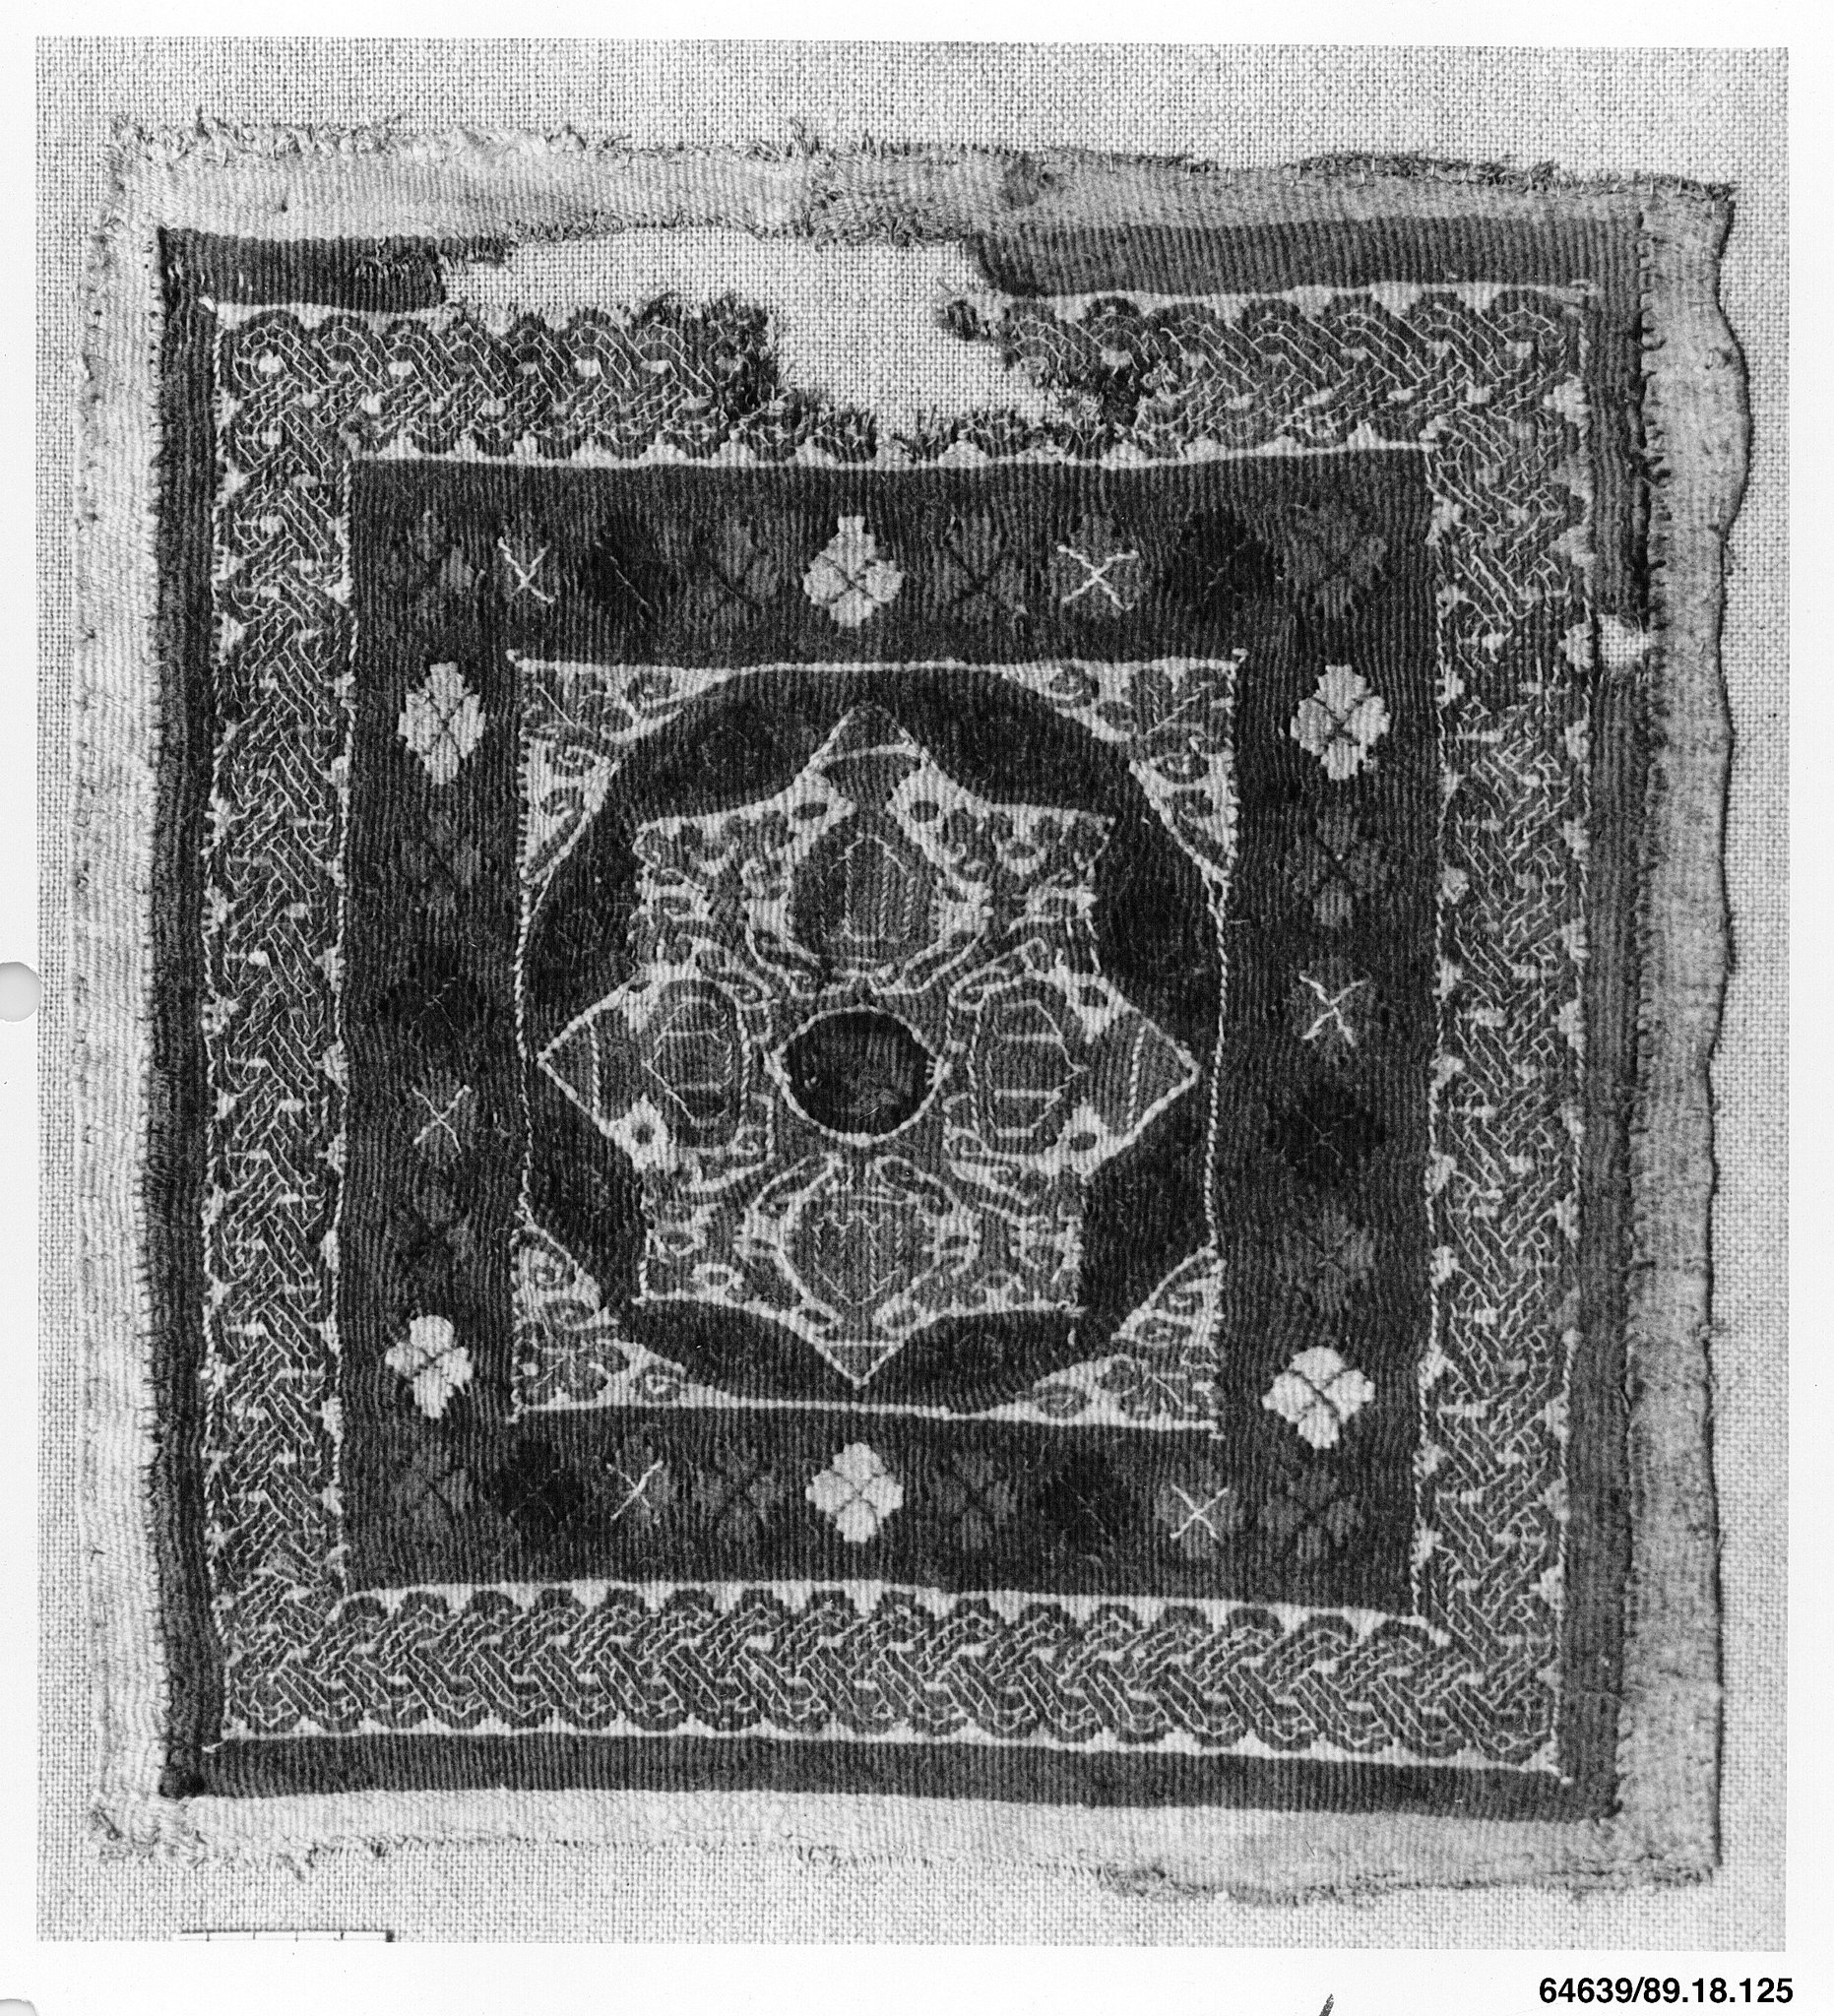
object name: textile fragment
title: Ornamental Tapestry Panel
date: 567-700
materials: linen, wool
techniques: weave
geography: egypt